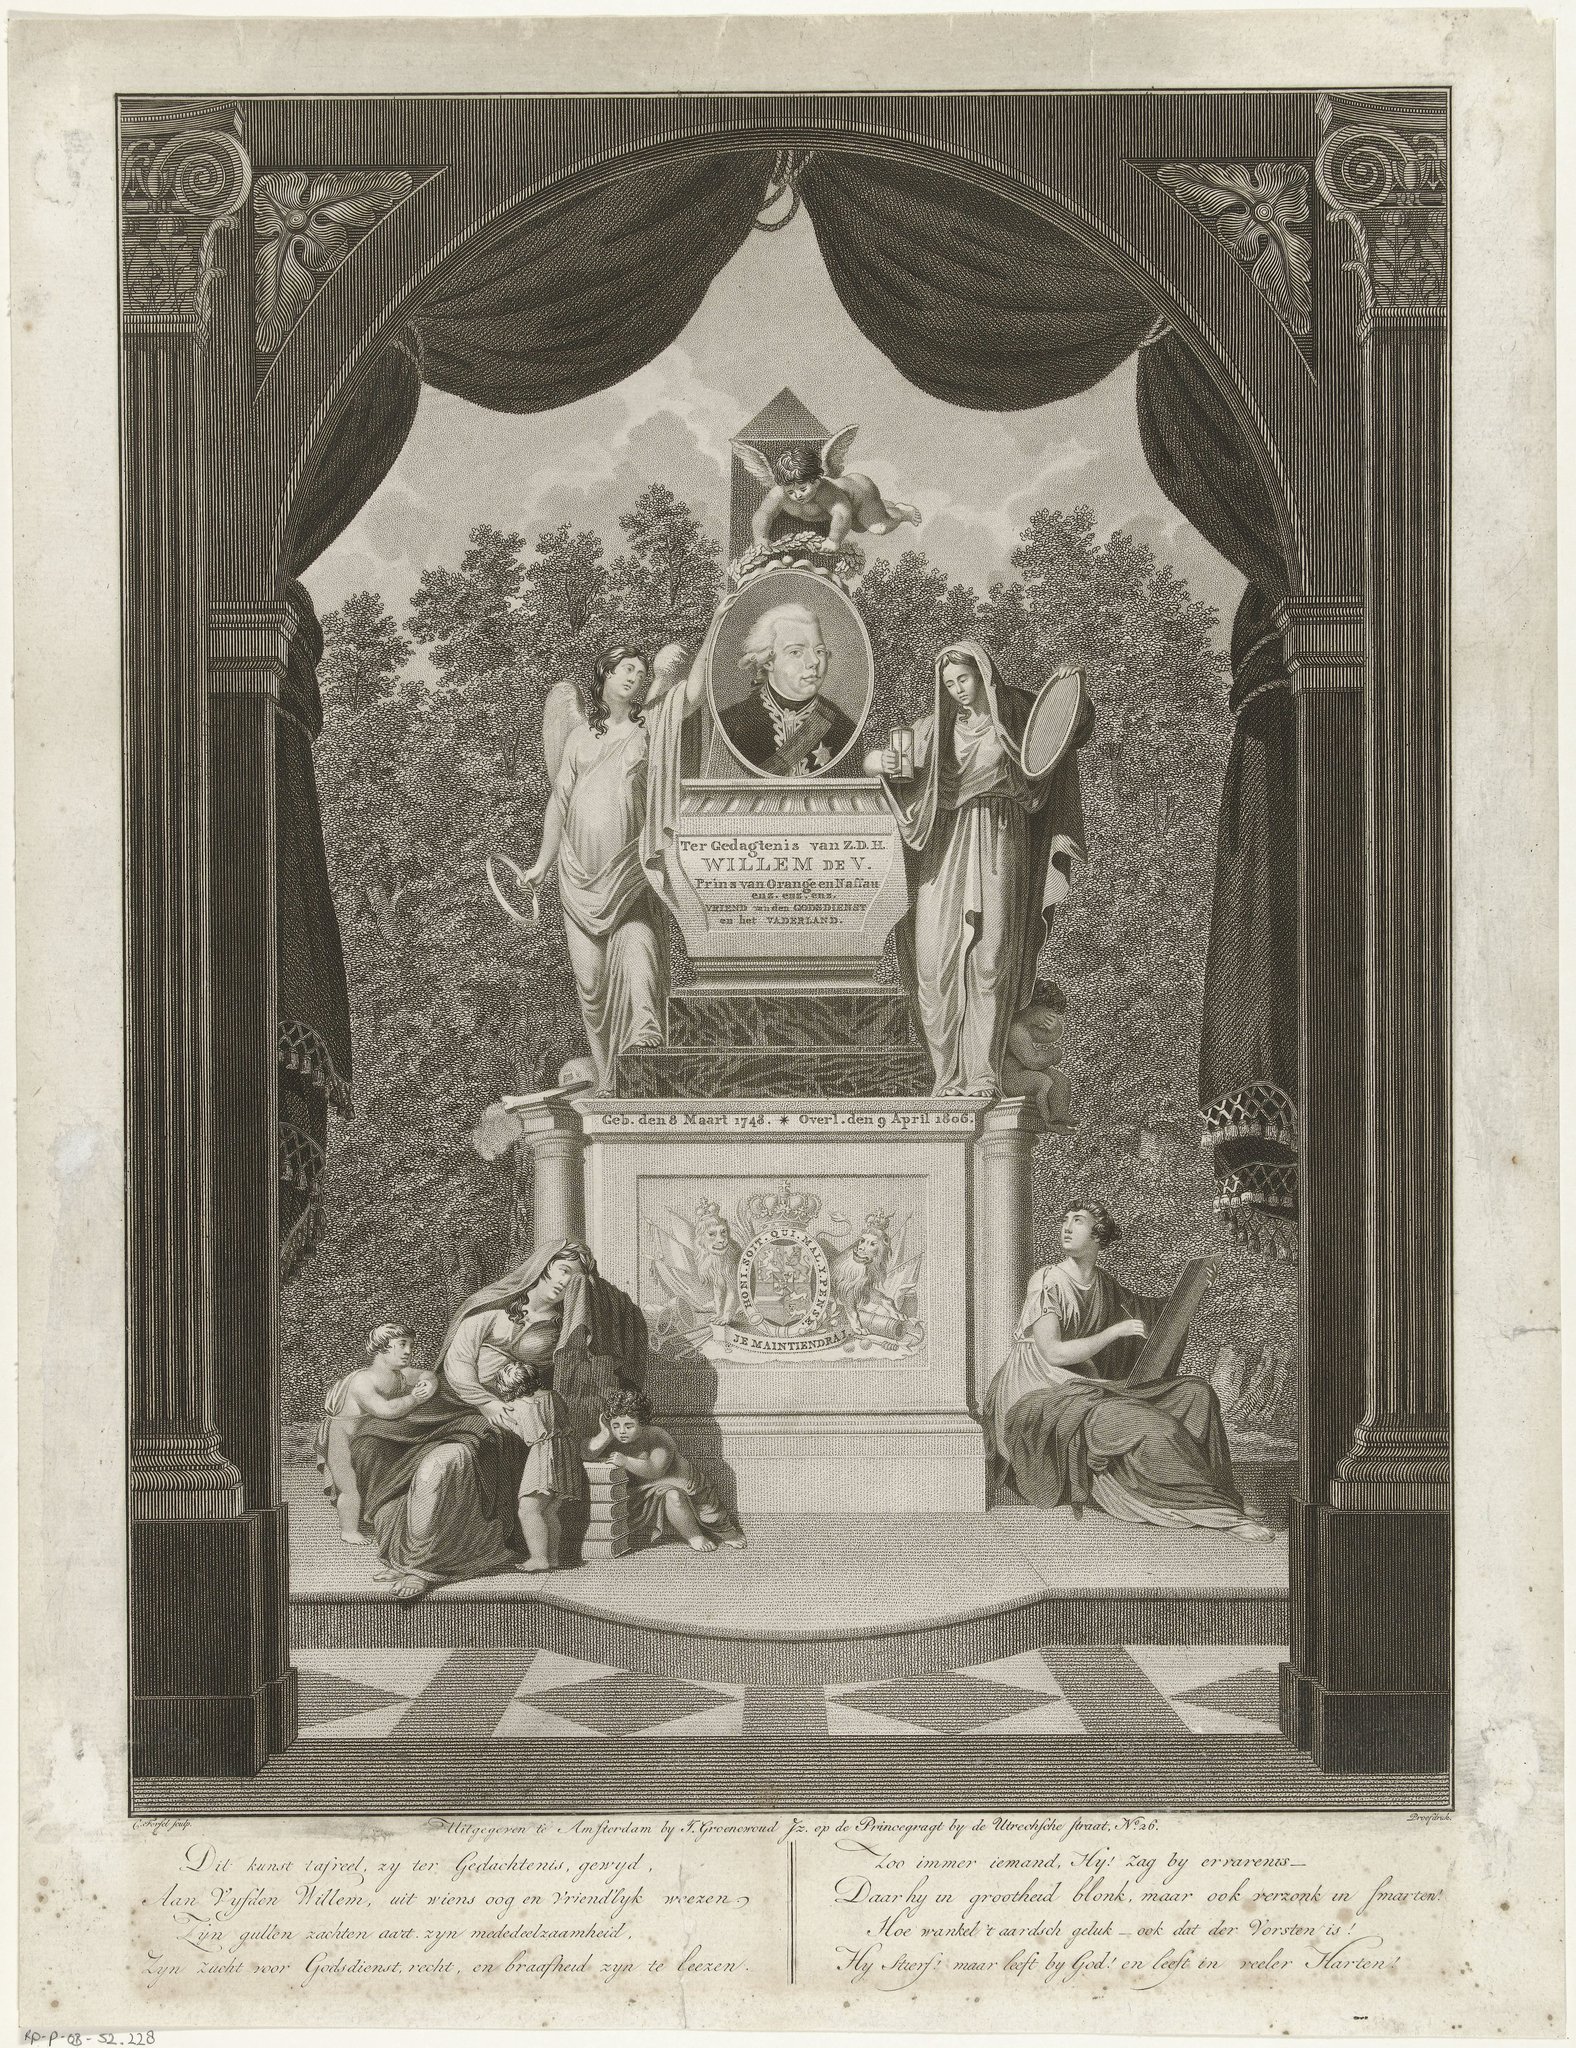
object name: print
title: Gedenksteen voor prins Willem V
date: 1806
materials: paper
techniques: etching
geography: amsterdam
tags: william v (prince of orange), other memorial structures, armorial bearing, heraldry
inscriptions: collector's mark: Lugt 2228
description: Gedenksteen voor Willem V, prins van Oranje-Nassau, getooid met een portret in ovaal dat door een putto gelauwerd wordt. Links en rechts van het portret staat een engel met een grote ring in haar hand, symbool van gezag en eenheid, en een gesluierde vrouw met een zandloper en spiegel. De sokkel van het monument is versierd met het wapen van de prins dat geflankeerd wordt door twee gekroonde leeuwen. Links op de grond leunt een wenende vrouw, omringd door drie kinderen, tegen de sokkel. Rechts zit een vrouw te tekenen. In de marge staat een vierregelige tekst in twee kolommen.